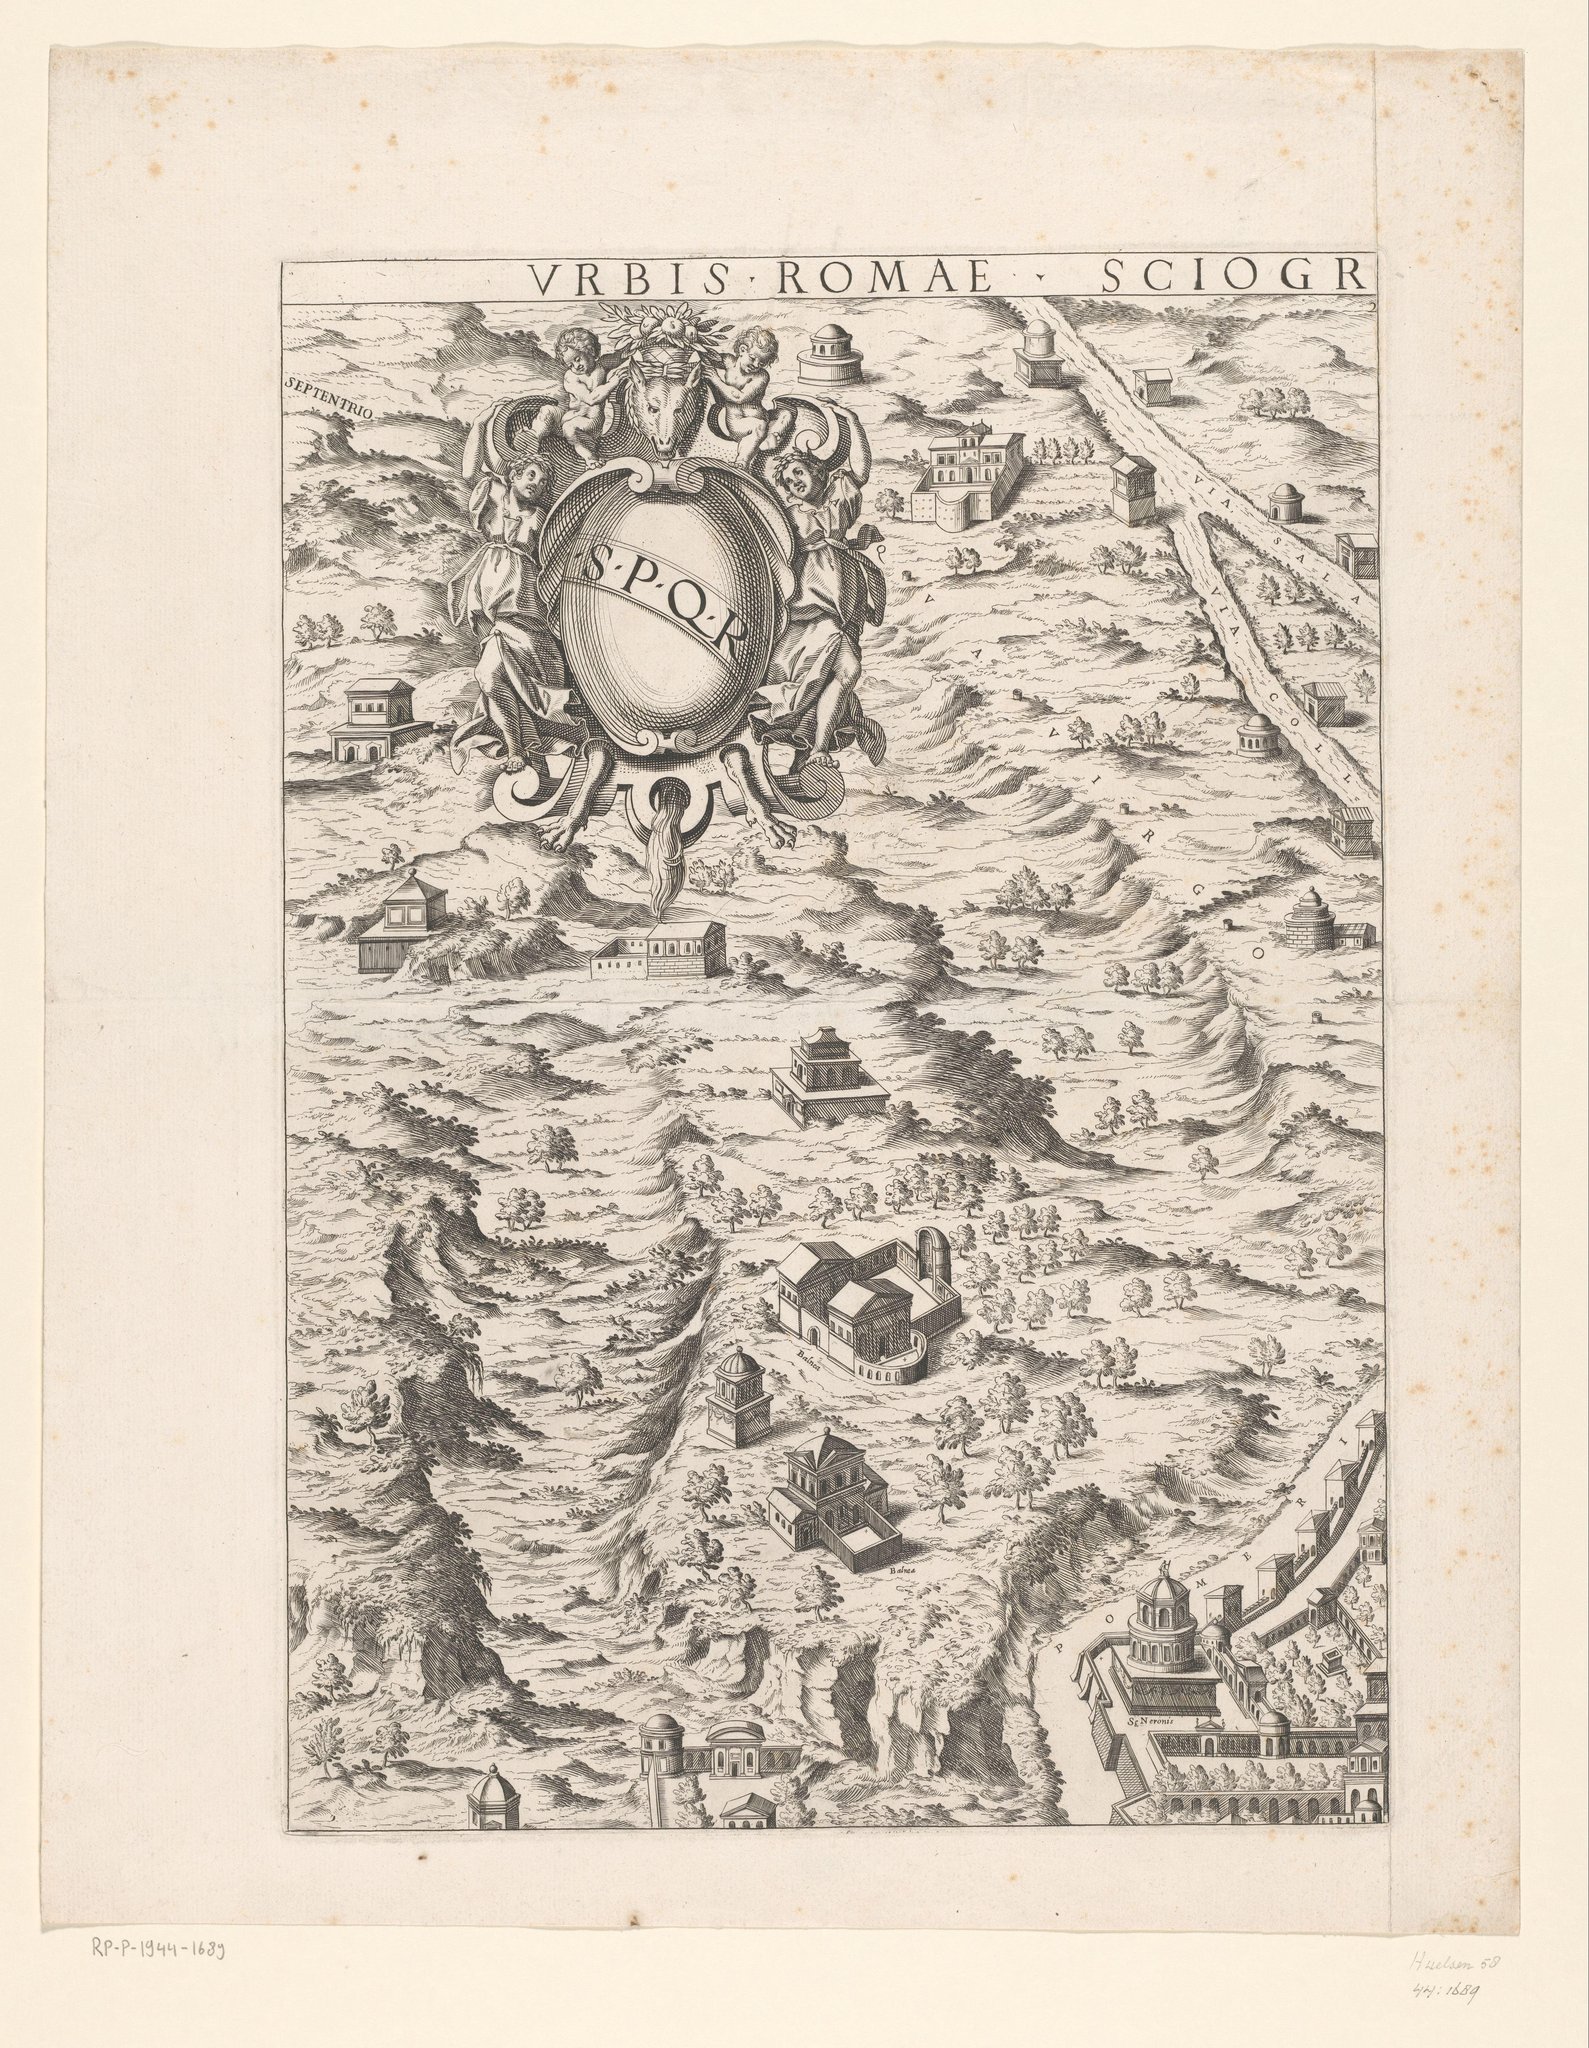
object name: print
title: Plattegrond van Rome in de Romeinse tijd (eerste deel)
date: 1639-1691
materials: paper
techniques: engraving, etching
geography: rome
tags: maps of cities, rome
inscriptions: collector's mark: Lugt 2228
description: Eerste deel van een plattegrond van Rome in vogelvluchtperspectief, bestaande uit acht delen. Rechtsboven genummerd: 2.